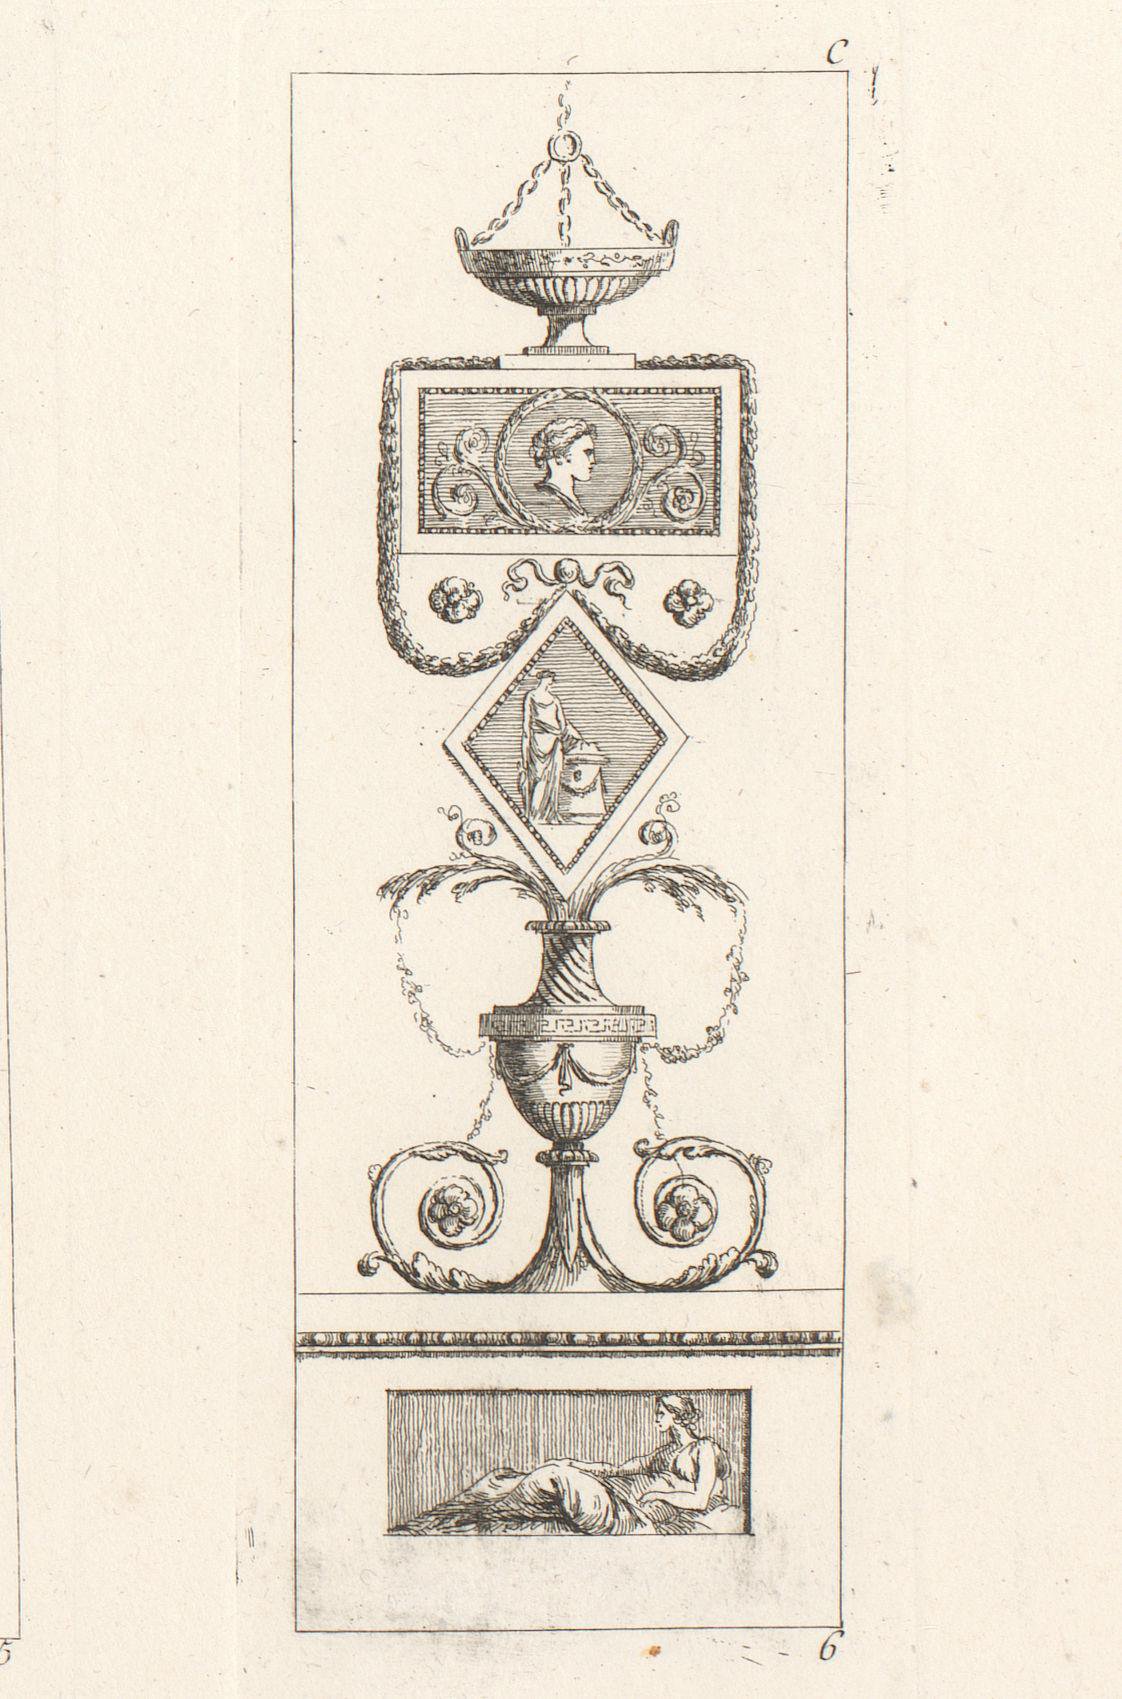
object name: album leaf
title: 3e. cahier d'arabesques inventés et gravés par F. Bo.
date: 1802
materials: paper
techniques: etching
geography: paris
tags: adult woman, ornament ~ arabesque, vase ~ ornament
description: Doordat dit album bestaat uit meerdere, deels eerder uitgegeven prentreeksen, is de datering niet consequent. Het geheel is op de titelpagina gedateerd op 1802. Deze reeks is niet los gedateerd. De serietitel voor het gehele werk is "Recueil d'arabesques, contenant les loges du Vatican". De andere serietitel is de titel van de specifieke reeks binnen het geheel.